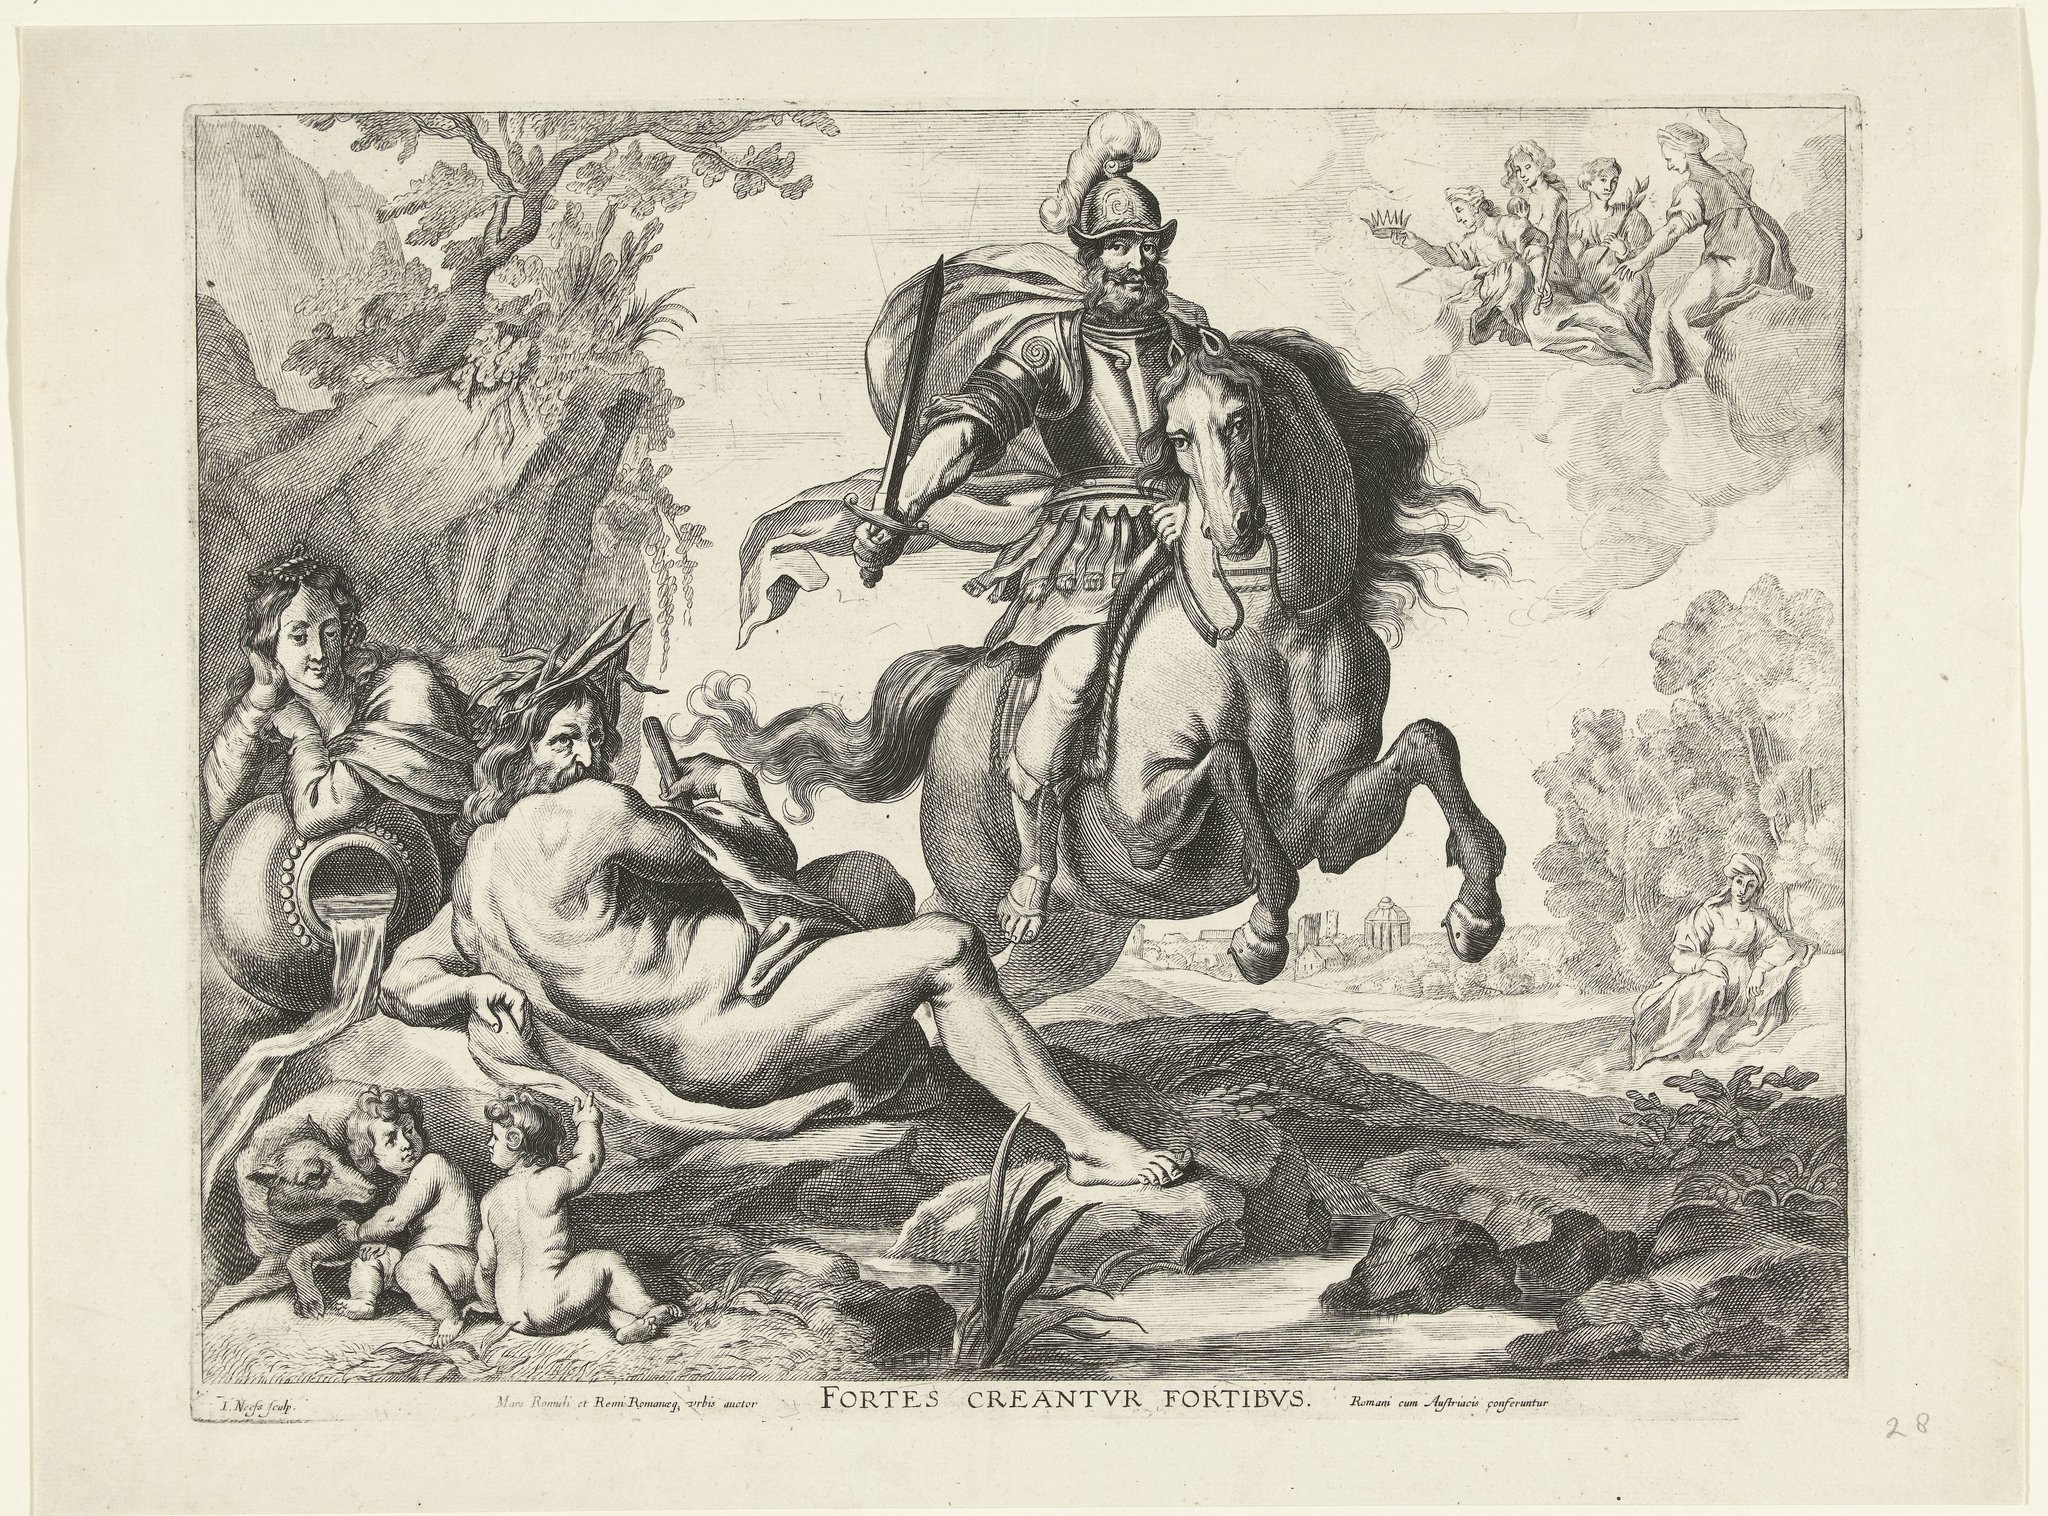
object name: print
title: Mars Romulie et Remi Romanaeq. urbis auctor / Fortes creantur fortibus / Romani cum Austriacus conferuntur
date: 1635-1636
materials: paper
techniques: engraving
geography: southern netherlands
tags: brussels, landvoogd der zuidelijke nederlanden ferdinand van oostenrijk, romulus and remus are washed ashore and suckled by a she-wolf; 'lupa romana', triumphal arch, specific aspects, allegorical aspects of mars; mars as patron, ghent, rome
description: De macht van Oostenrijk vergeleken met Rome. Mars te paard met de bij de wolfin zogende Romulus en Remus. Voorstelling op de voorzijde van de triomfpoort Arcus Caroli op de Vrijdagmarkt. Blad nr. 28 in een geheel van 42 platen die de uitgave van de beschrijving van de intocht van de Kardinaal Infant Ferdinand van Oostenrijk te Gent op 28 januari 1635 als de nieuwe landvoogd voor de Spaanse Nederlanden illustreren.